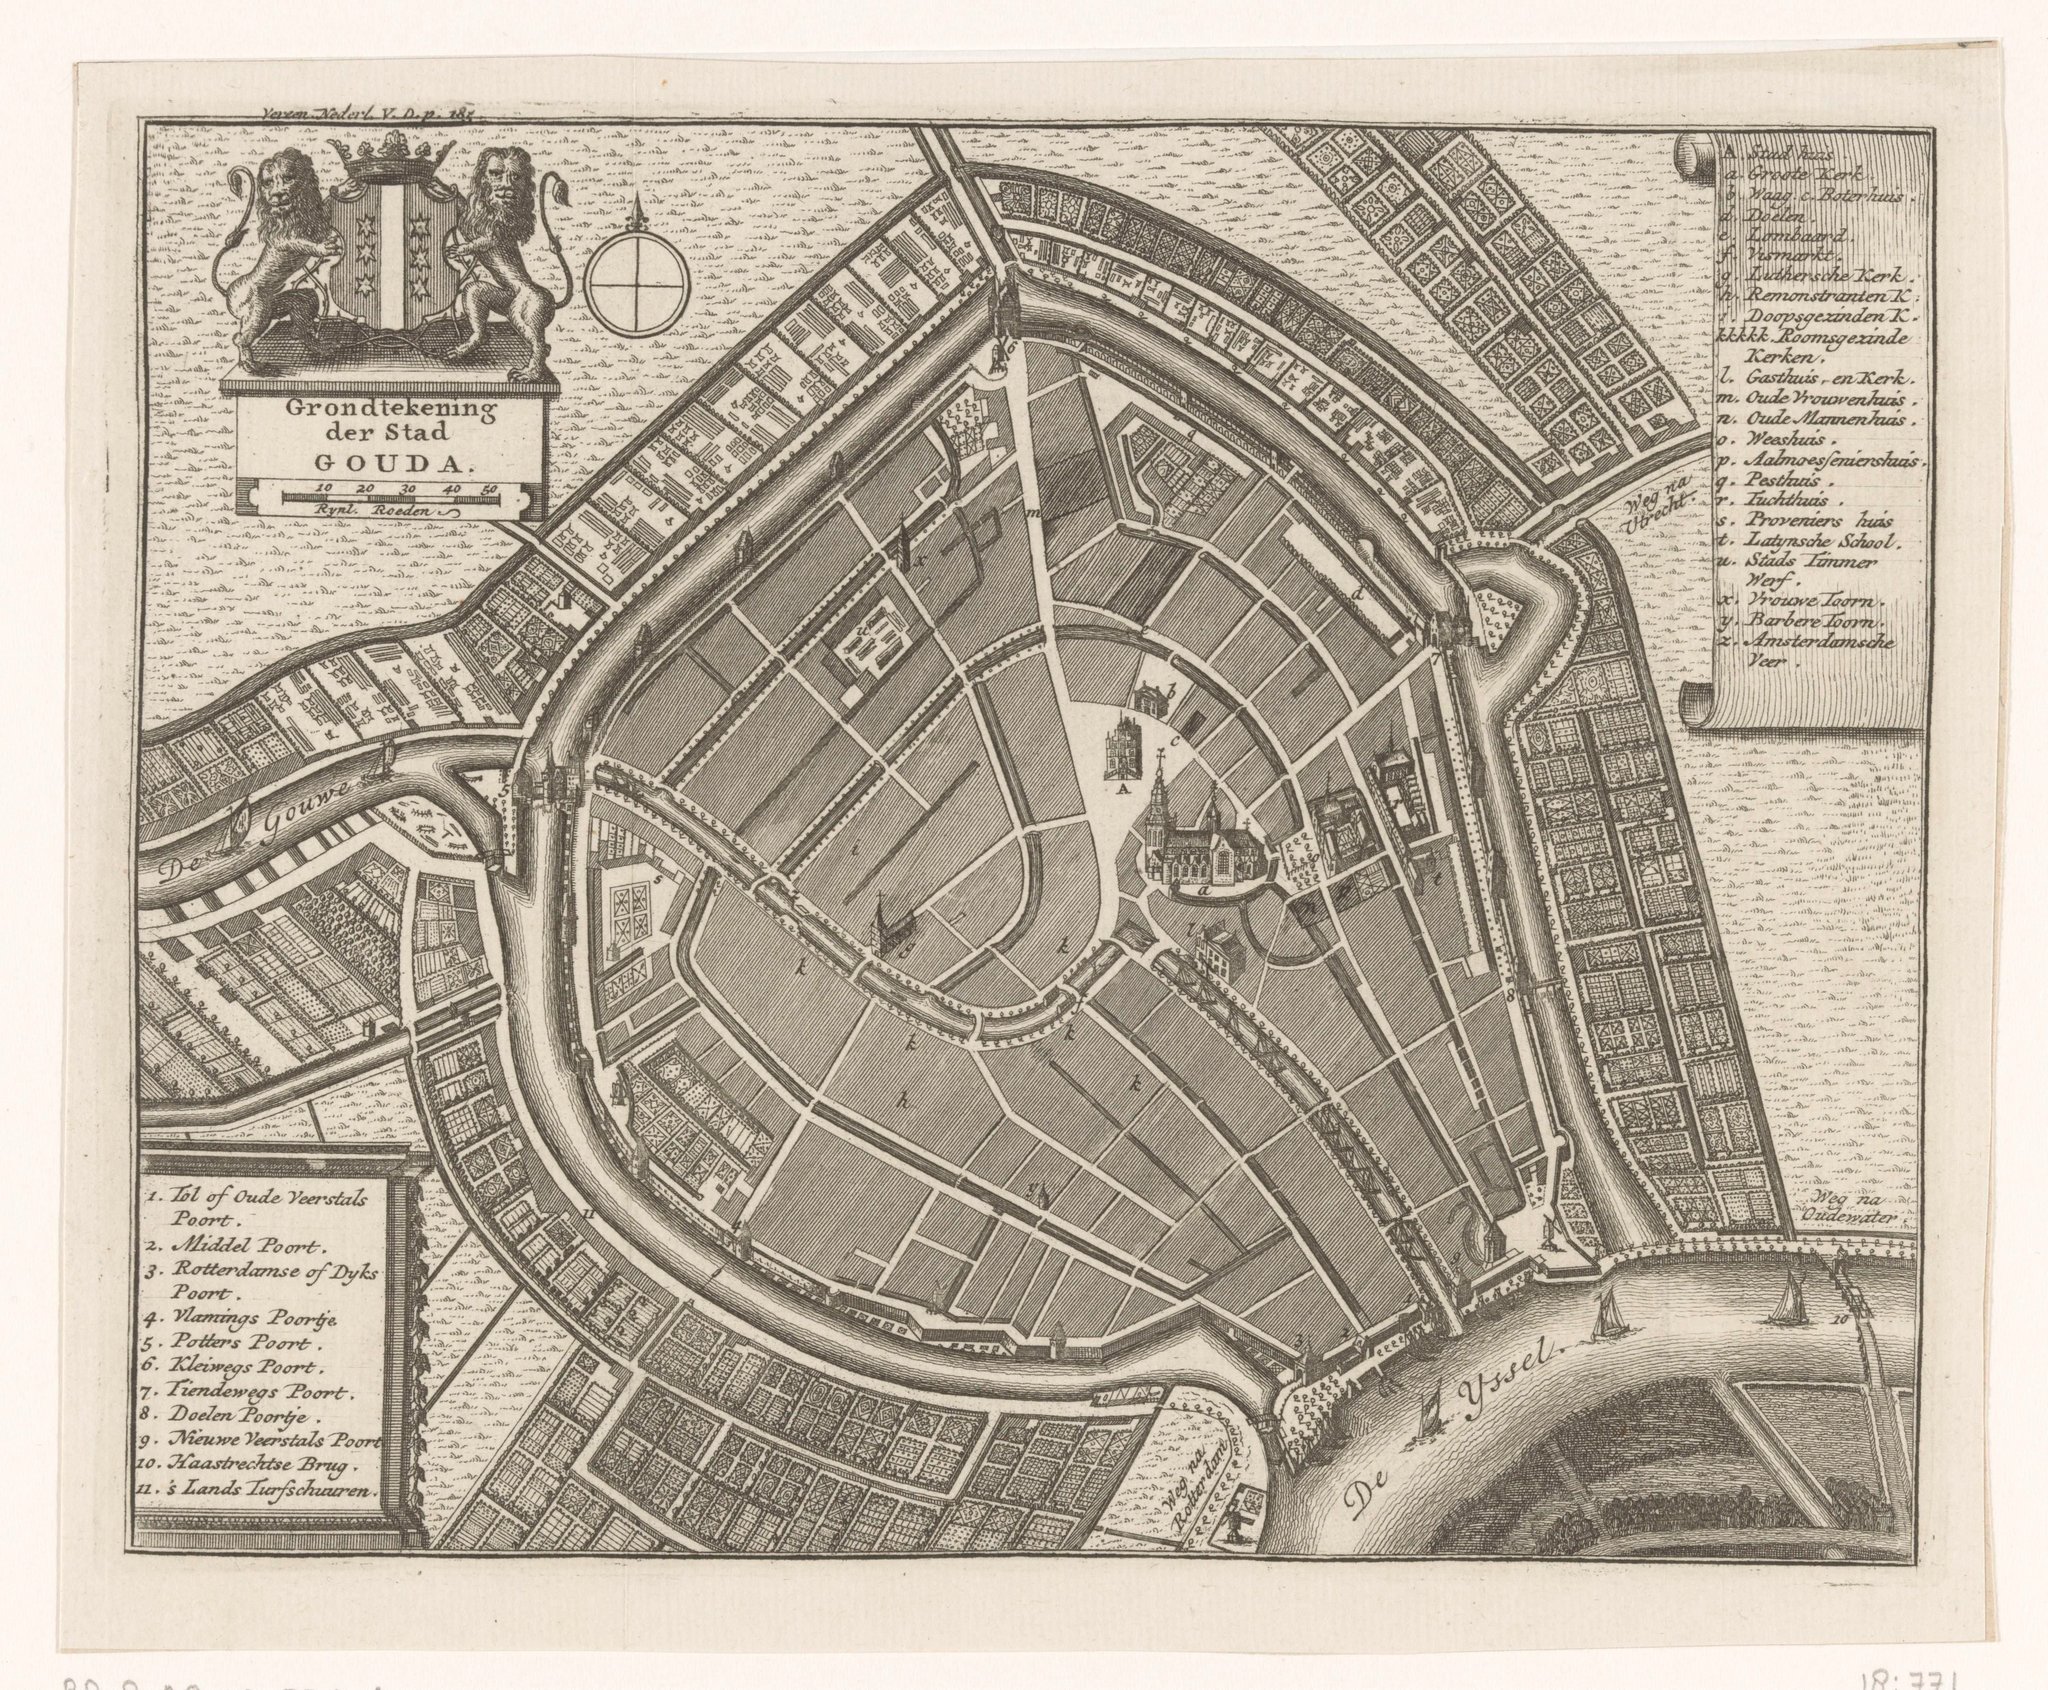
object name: area plan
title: Plattegrond van Gouda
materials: paper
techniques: engraving, etching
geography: amsterdam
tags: coat of arms (as symbol of the state, etc.) (+ city; municipal), maps of cities, gouda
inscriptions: collector's mark: Lugt 2228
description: Prent gebruikt in: Wagenaar, Jan. Tegenwoordige staat der Vereenigde Nederlanden, vyfde deel. Behelzende het vervolg der beschrijvinge van Holland. Met naauwkeurige plans der steden en printverbeeldingen versierd / Hedendaagsche historie, of tegenwoordige staat van alle volkeren; XVde deel (…). Amsterdam: Isaak Tirion, 1744, tussen p. 184 en 185. En in: Beknopte atlas, van omtrent honderd platte gronden der voornaamste vestingen, kasteelen en steden van Europa, en byzonder van de Nederlanden en eenige kolonien (…). Amsterdam: Compagnie van Boekverkopers, s.a. [na 1780].